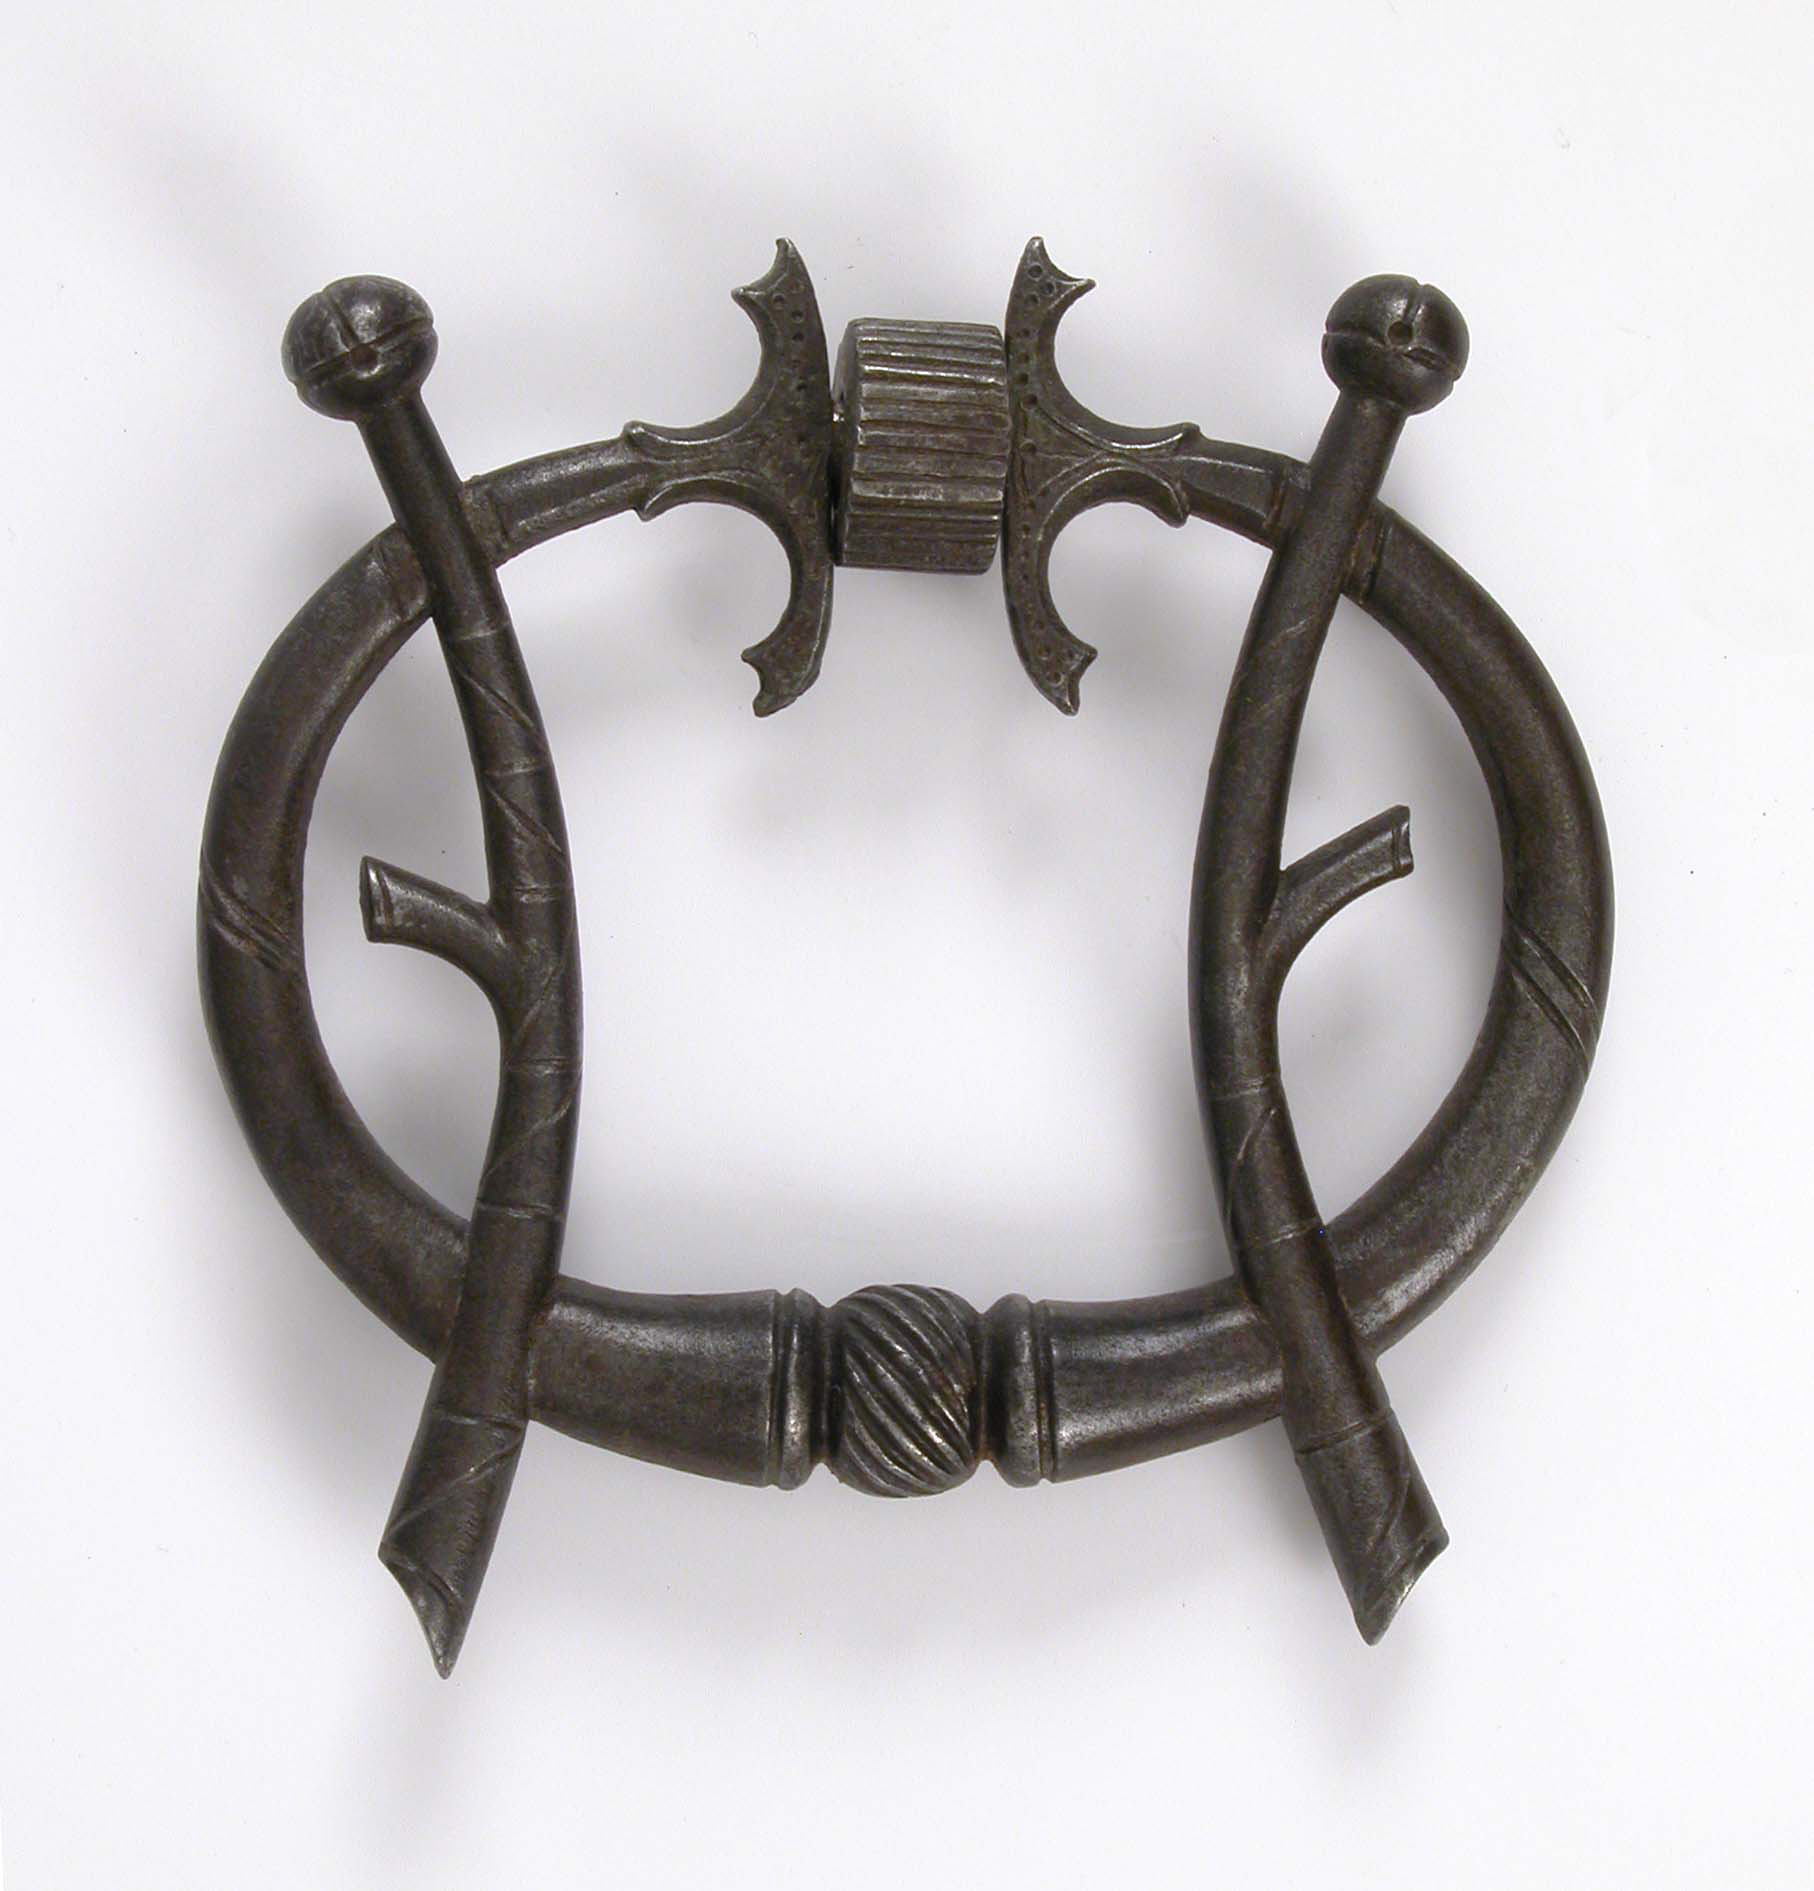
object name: door handle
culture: german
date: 1501-1600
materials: iron